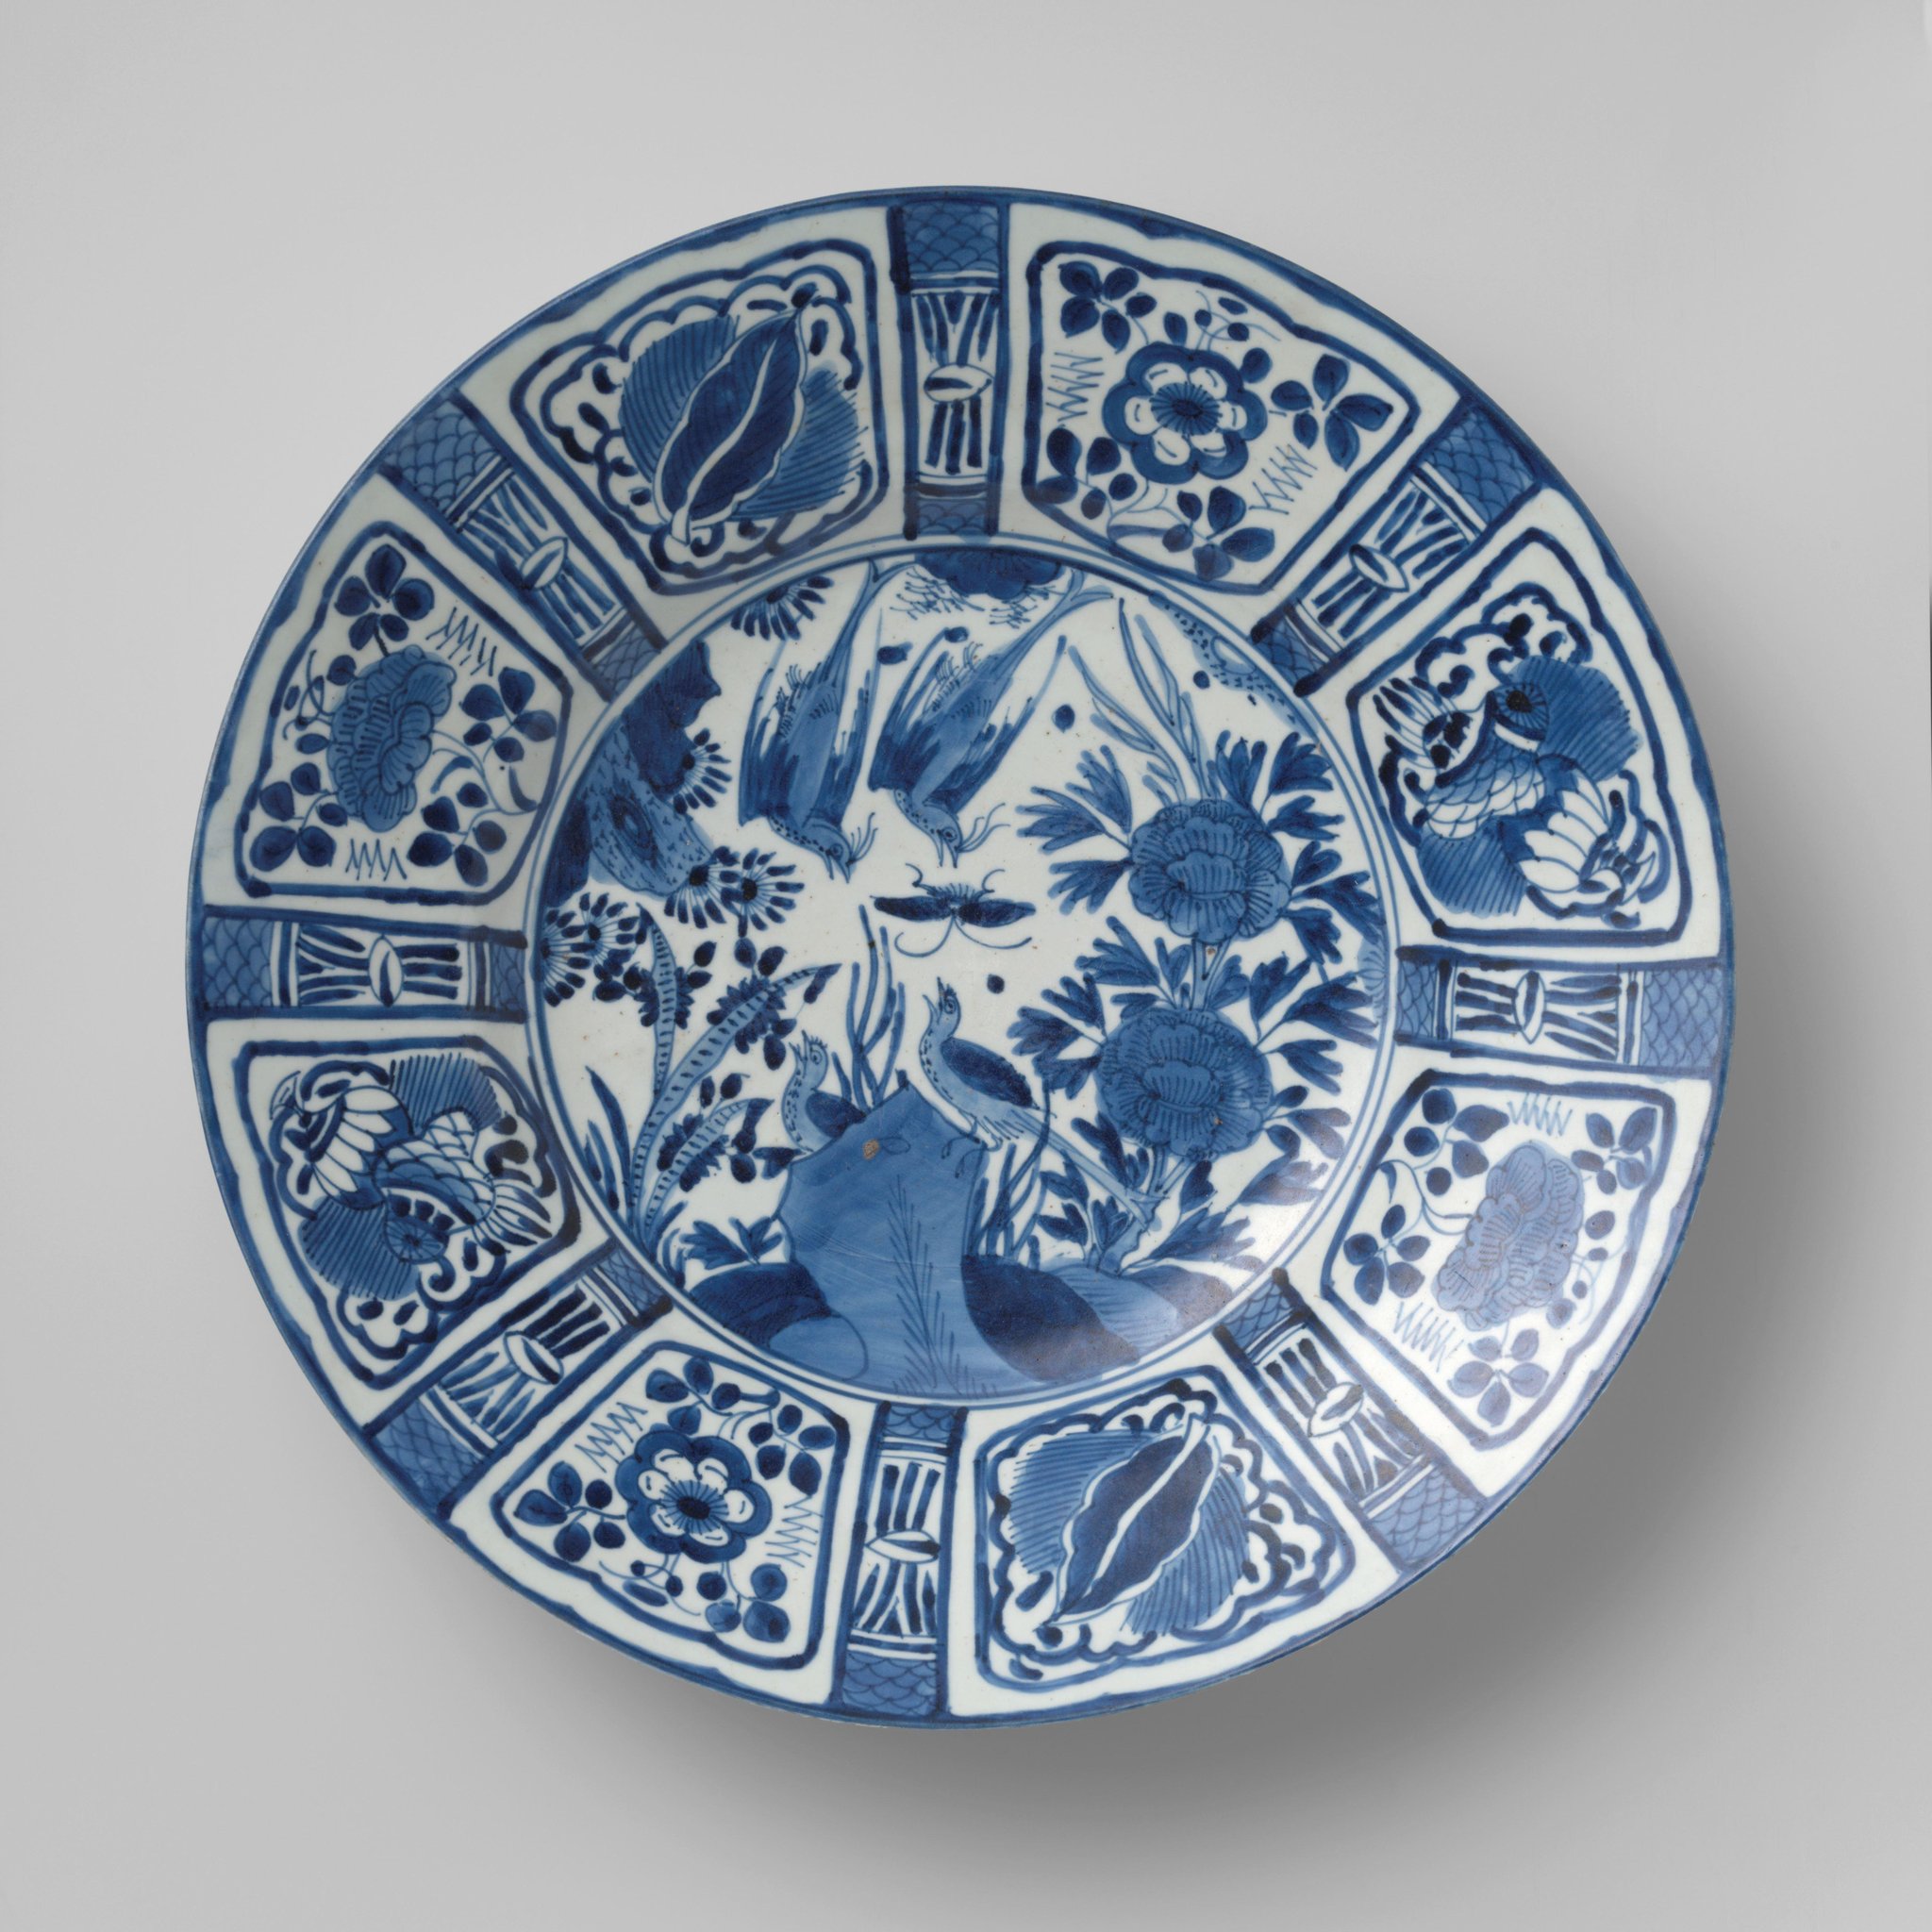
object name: platter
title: Dish with birds and a butterfly near rocks and flowering plants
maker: Anonymous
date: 1650-1700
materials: cobalt, glaze, paint, porcelain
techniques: firing, turning, vitrification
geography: japan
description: Schotel van porselein met een brede rand, beschilderd in onderglazuur blauw. Op het plat twee vliegende vogels en een vlinder; nog twee vogels op een rots omgeven door bloeiende planten. De wand en rand is verdeeld in afwisselend brede en smalle vakken met bloemtakken en gelukssymbolen. De buitenwand met drie bloemtakken. Gemerkt op de onderzijde met een zegelmerk. Decoratie in navolging van het Chinese kraakporselein. Drie proenen op de onderzijden. Blauw-wit.